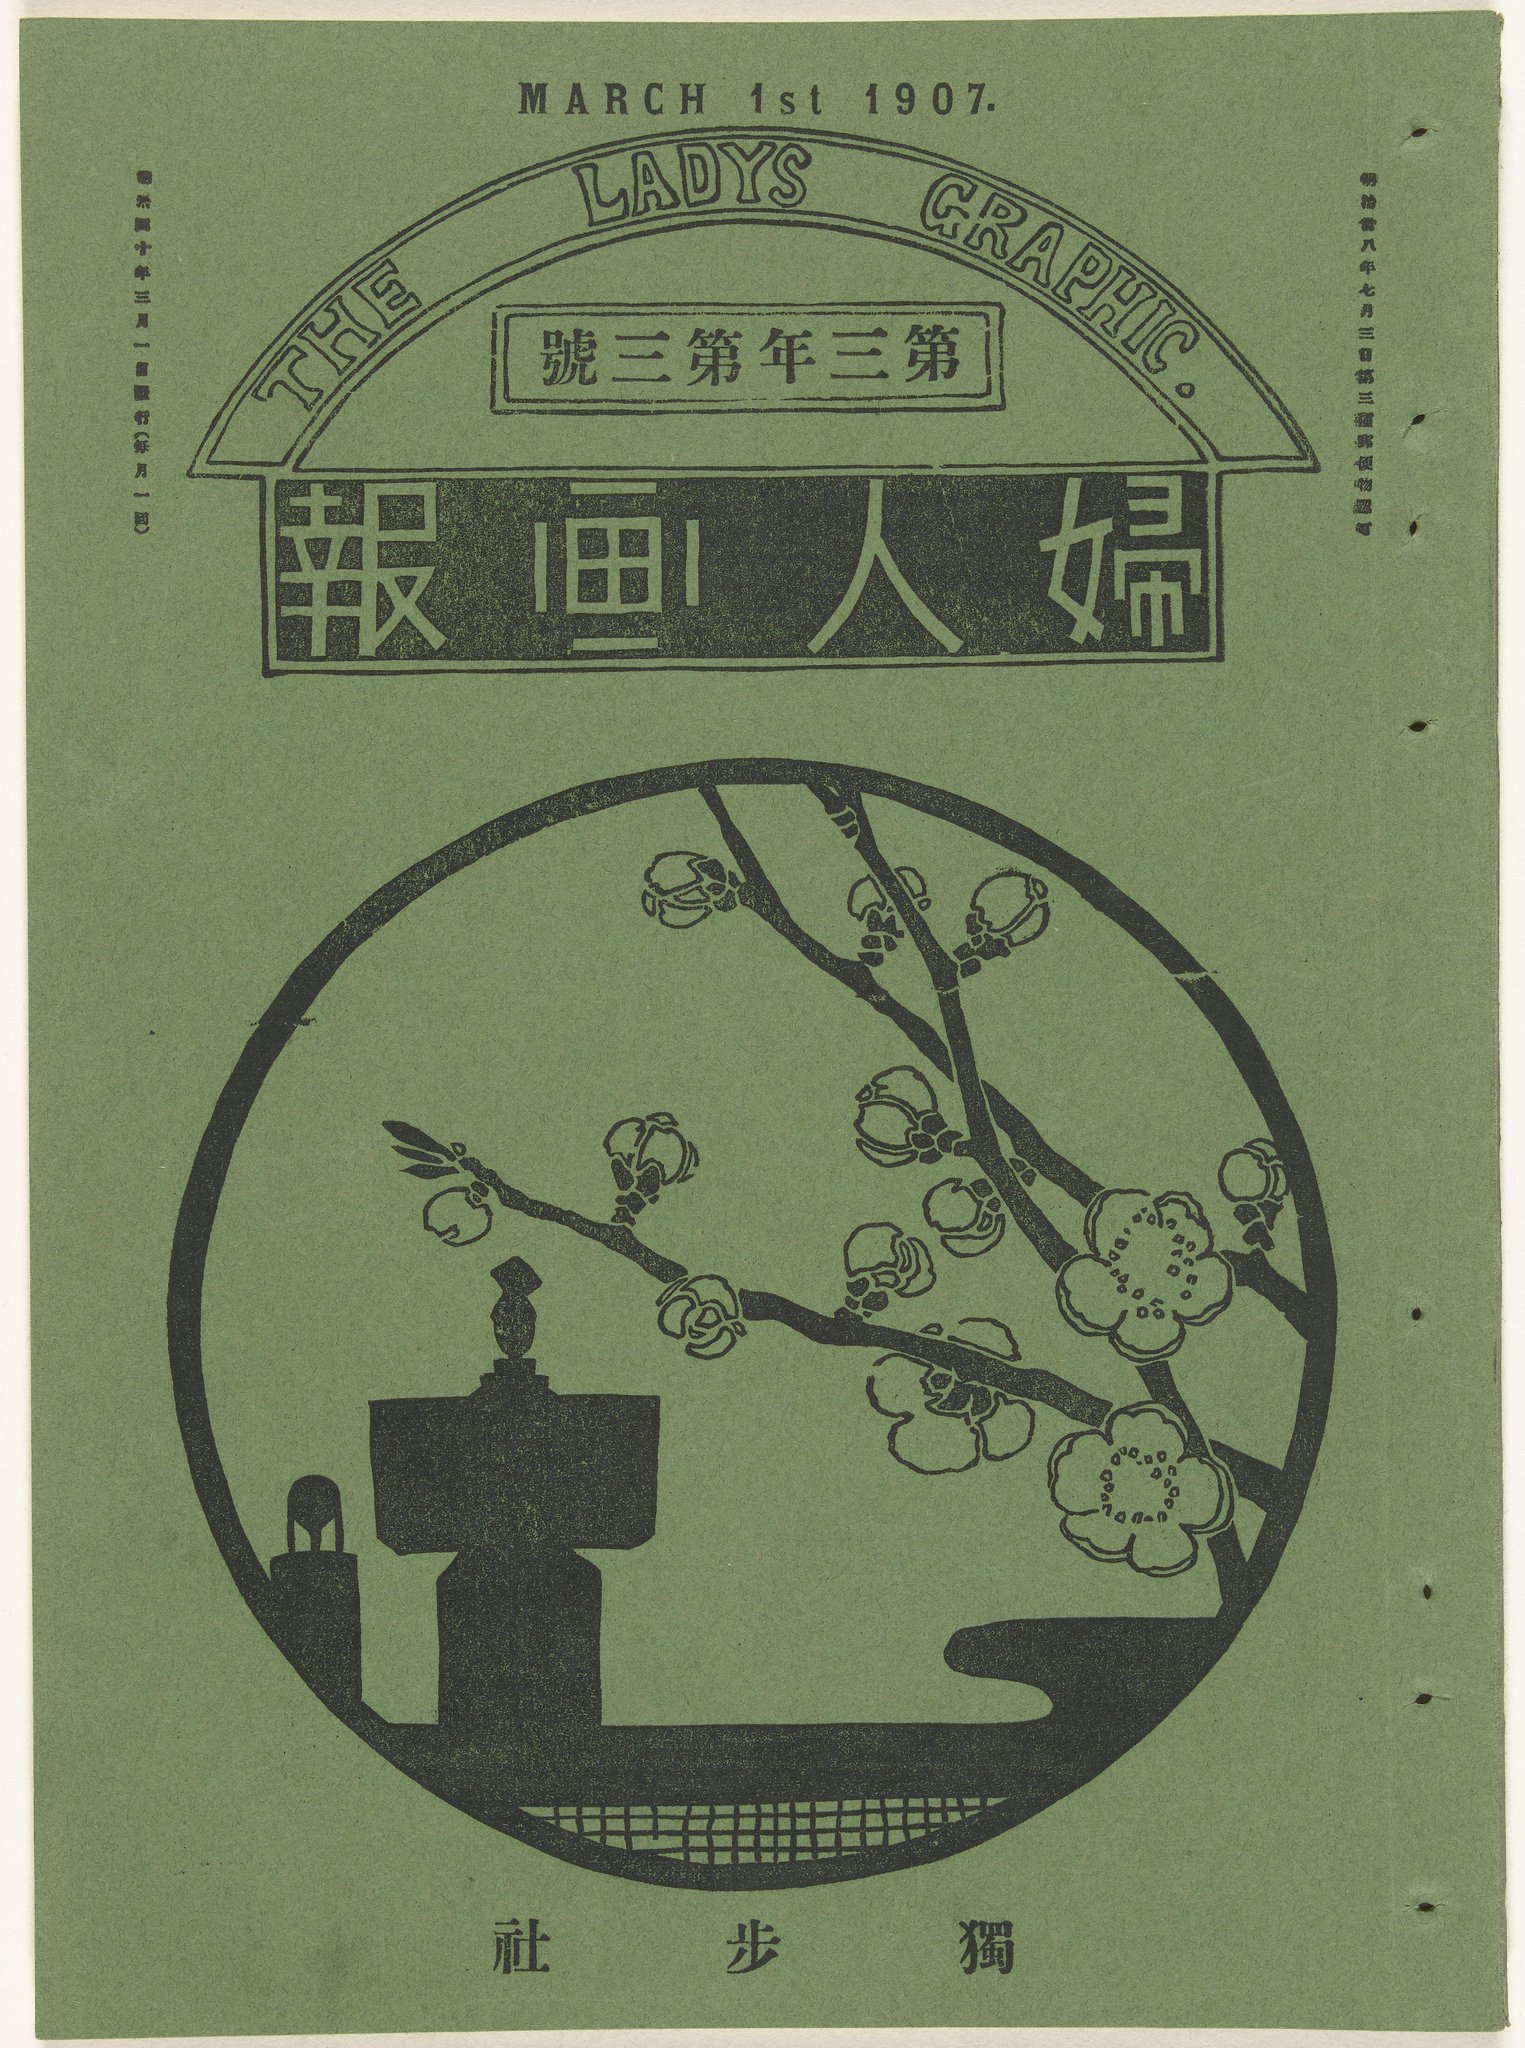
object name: magazine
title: The lady's graphic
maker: mitsutani kunishiro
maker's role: designer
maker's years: 1874-1936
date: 1907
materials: paper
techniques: letterpress printing, lithograph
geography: japan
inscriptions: date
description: Nummer 3 van de derde jaargang (maart 1907) van het tijdschrift Fujin gaho: groene kaft pruimenbloesem takken in cirkelvormig cartouche; binnenin, frontispies waarop twee vrouwen in boomgaard.